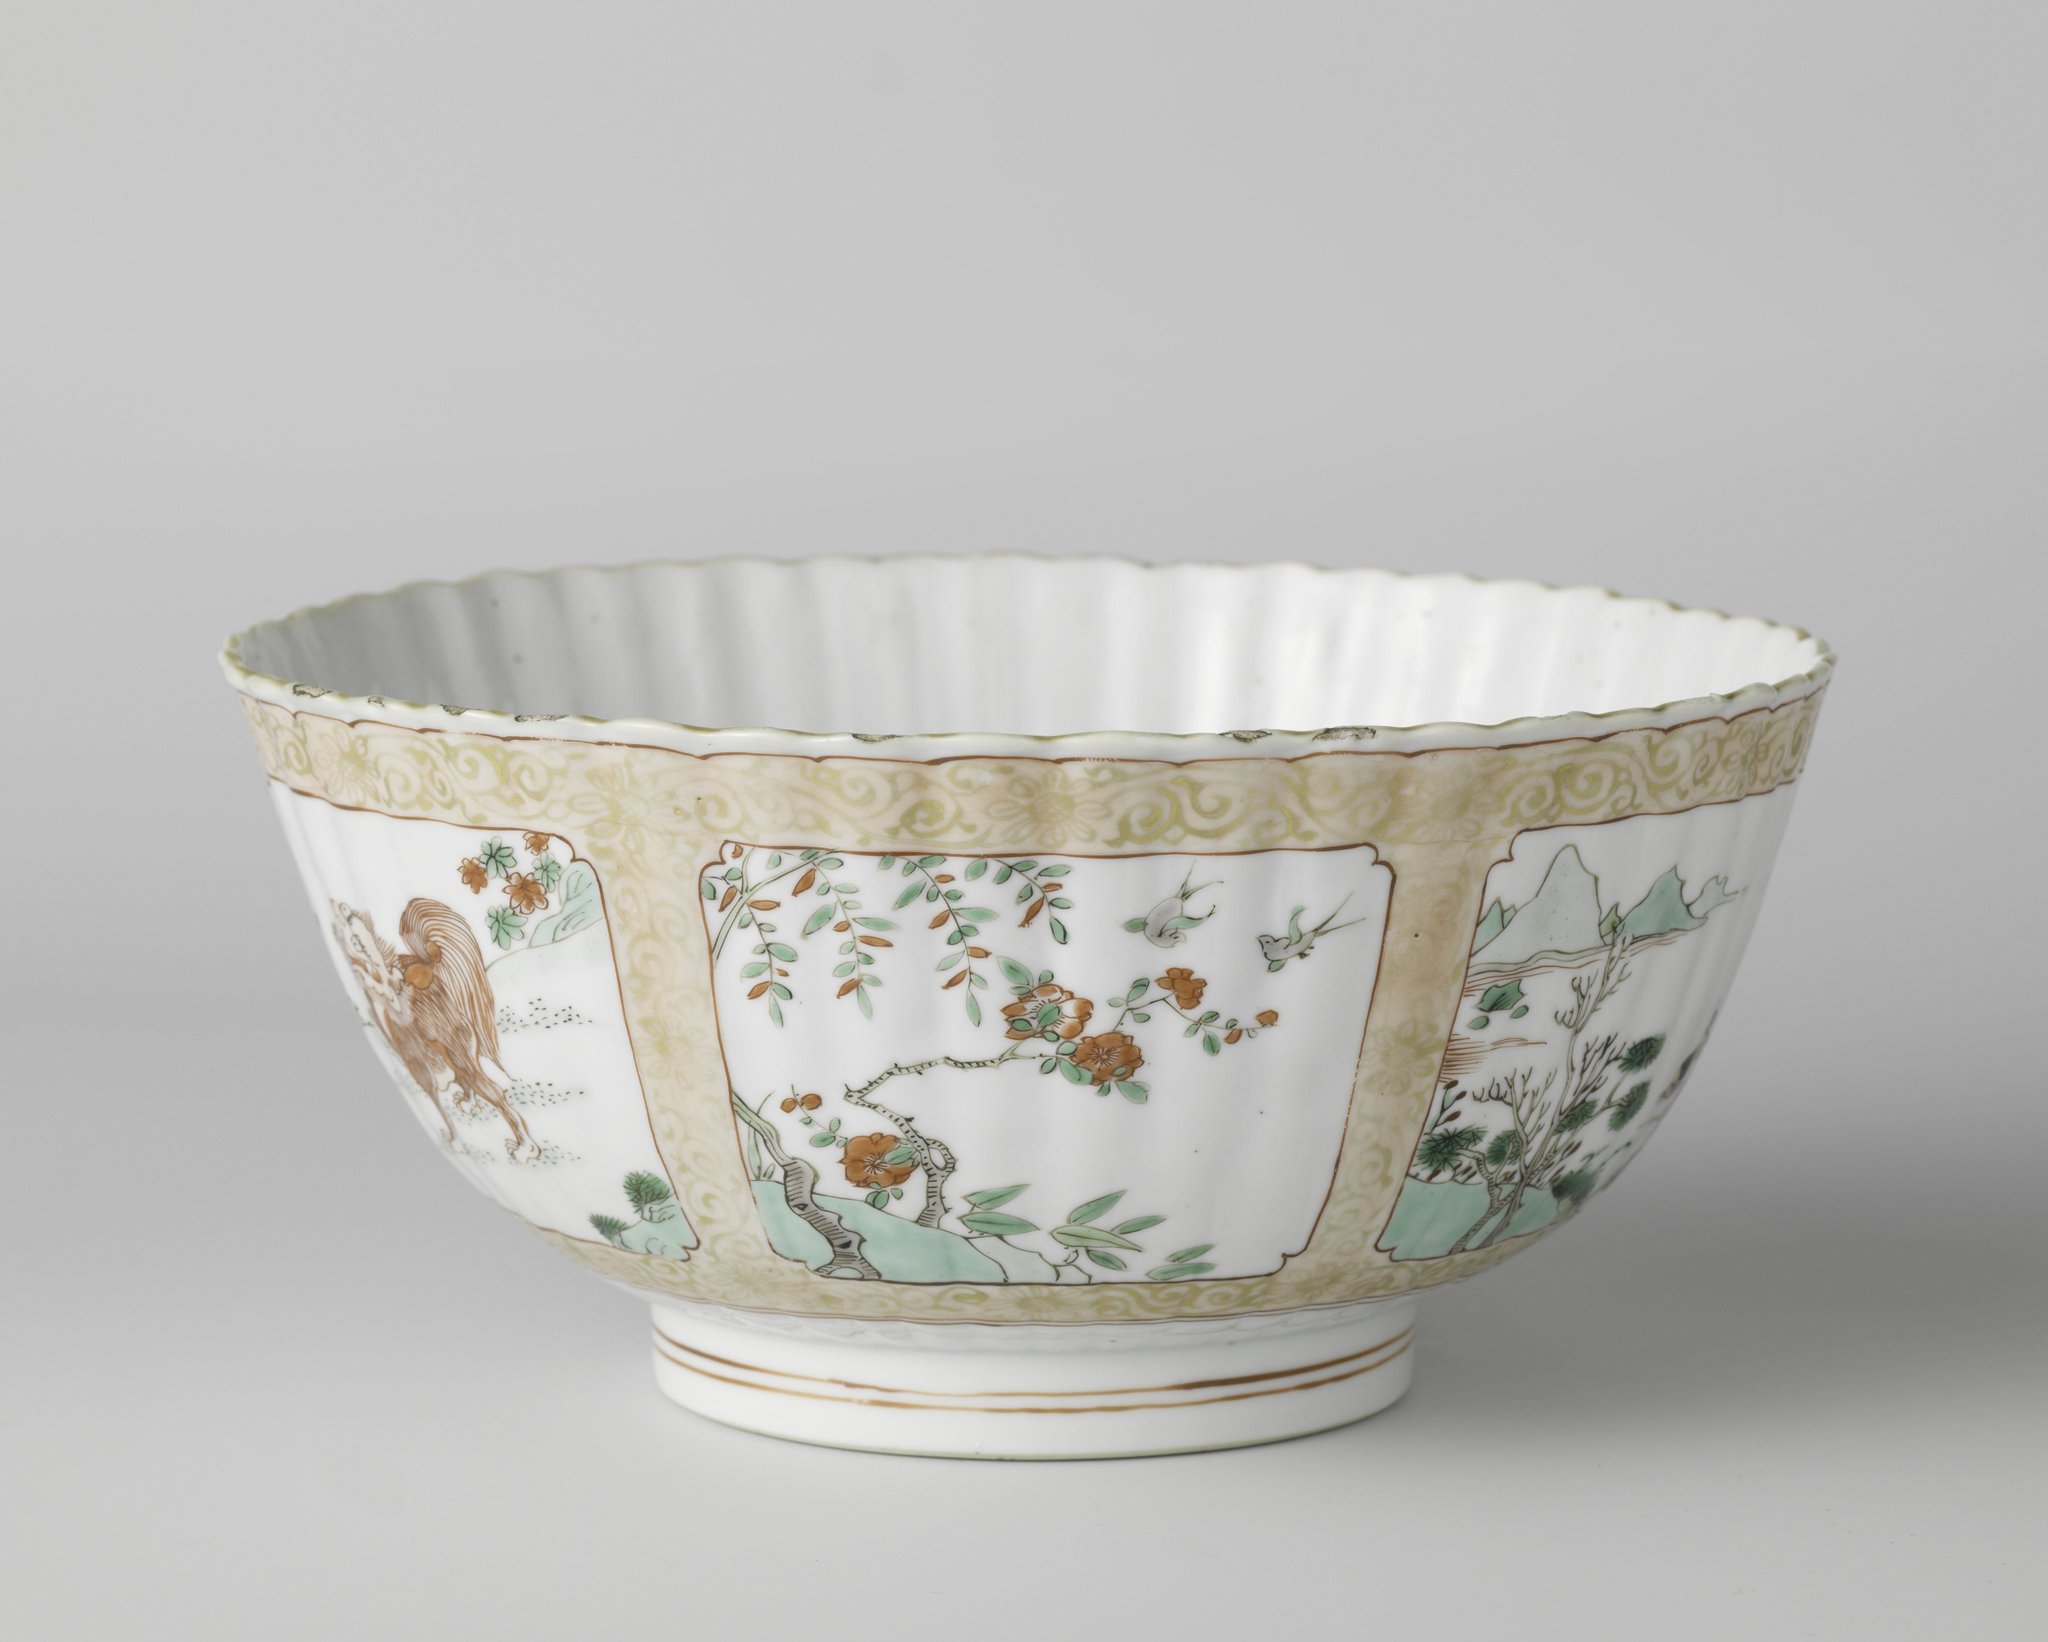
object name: bowl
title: Bowl with landscapes, mythological animals and flowers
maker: Anonymous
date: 1700-1725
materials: glaze, gold, paint, porcelain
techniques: firing, gilding, turning, vitrification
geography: china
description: Geschulpte kom van porselein met uitlopende wand, beschilderd op het glazuur in rood, groen, geel, aubergine, zwart en goud met landschappen, dieren en bloemen. De wand is verdeeld in zes cartouches tegen een roze grond met gestileerde bloemranken in goudemail; de vakken zijn gevuld met tweemaal een landschap met bergen, rivieren, bomen en personen, tweemaal met een shishi (leeuwhond) in een landschap en tweemaal met een prunustak en vogels. Op de bodem een jongen (zotje) tussen pioenranken. Famille verte.